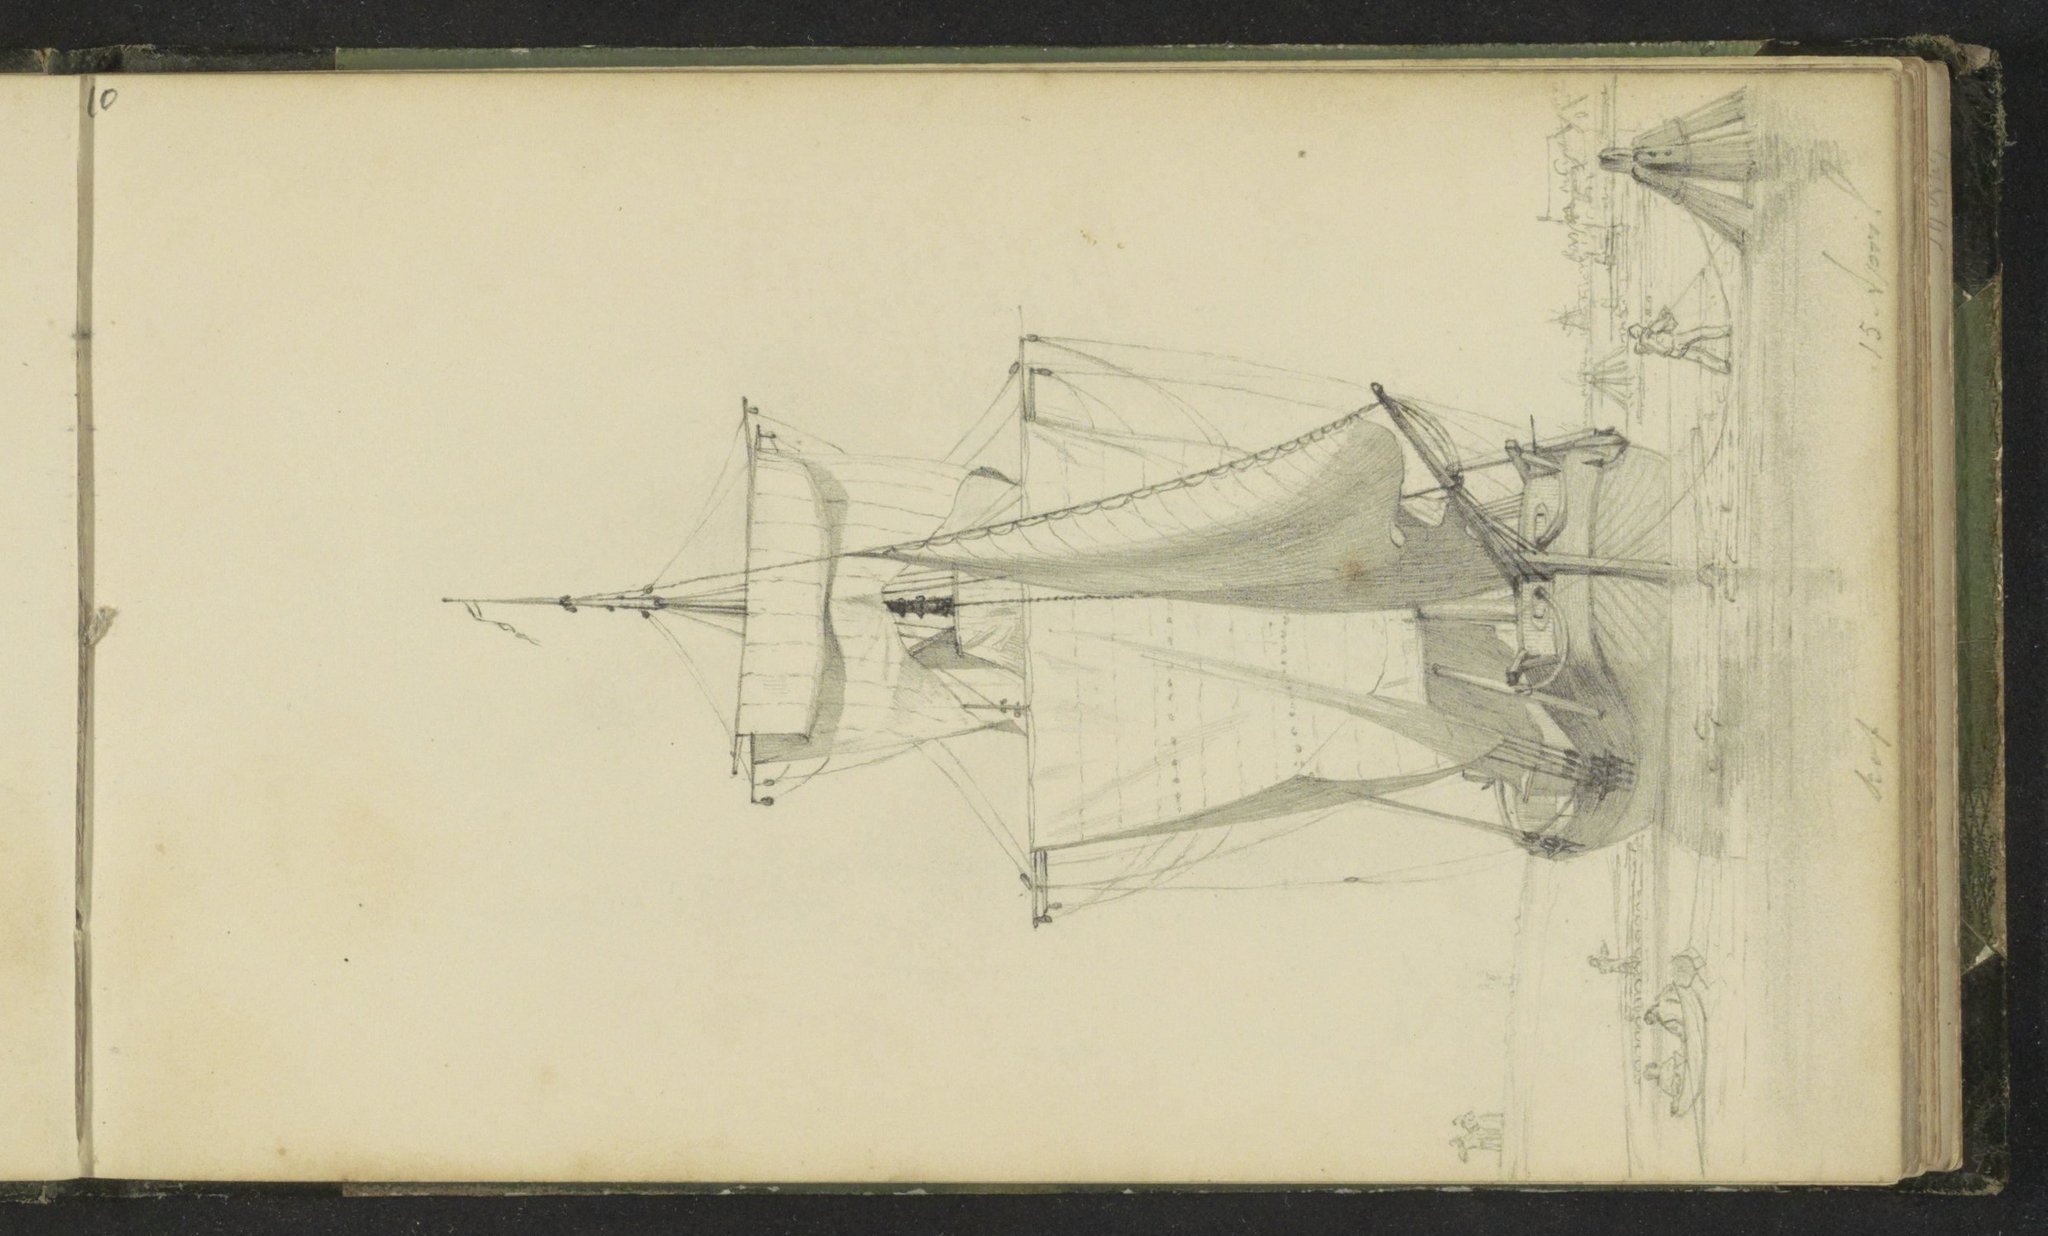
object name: sketchbook leaf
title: Afgemeerd kot voor een kust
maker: hendrik abraham klinkhamer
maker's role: draughtsman, painter, print maker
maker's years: 1810-1872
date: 1804-1843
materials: paper, pencil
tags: sailing-ship, sailing-boat, coast (+ landscape with figures, staffage)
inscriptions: date and inscription: ‘kot 15 April’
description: Blad 10 recto uit een schetsboek met 40 bladen.